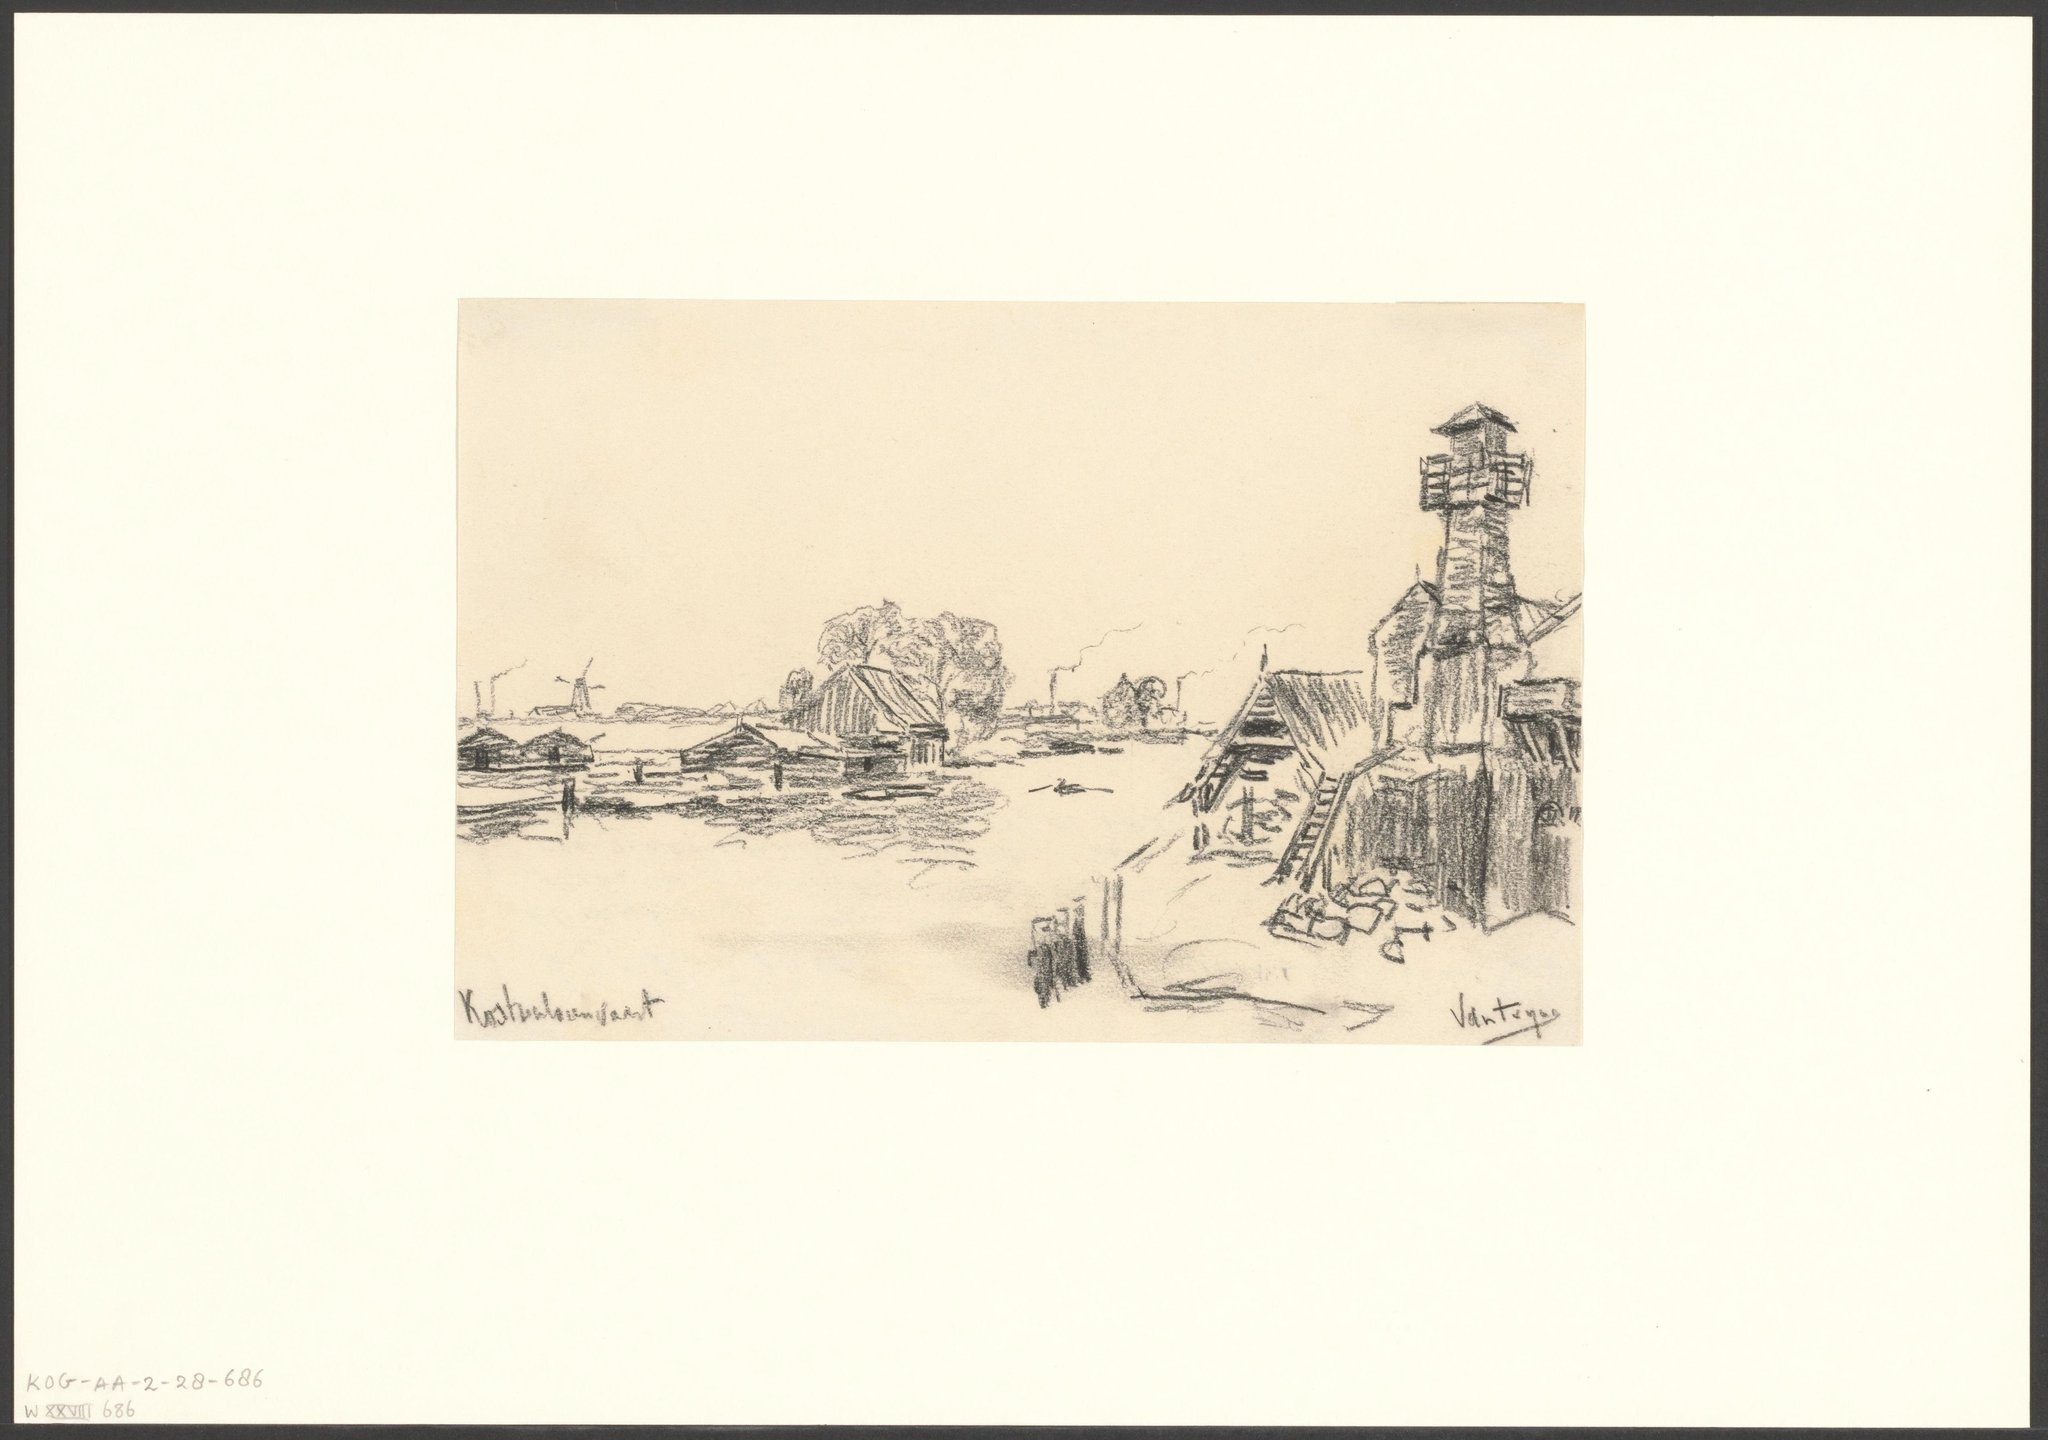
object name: drawing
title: Gezicht op de Kostverlorenvaart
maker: anthonie van teijn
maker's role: draughtsman, painter, print maker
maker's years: 1863-1943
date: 1907-1927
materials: chalk, paper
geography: amsterdam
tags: city-view in general; 'veduta', canal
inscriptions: collector's mark: Lugt 800a, inscription: ‘De Kostverloren vaart (...) Juli 1927- / vanEck’, signature: ‘VanTeyne’, inscription: ‘Kostverlorenvaart’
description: Tekening binnen de Atlas Van Eck ingedeeld op wijknummer 28.